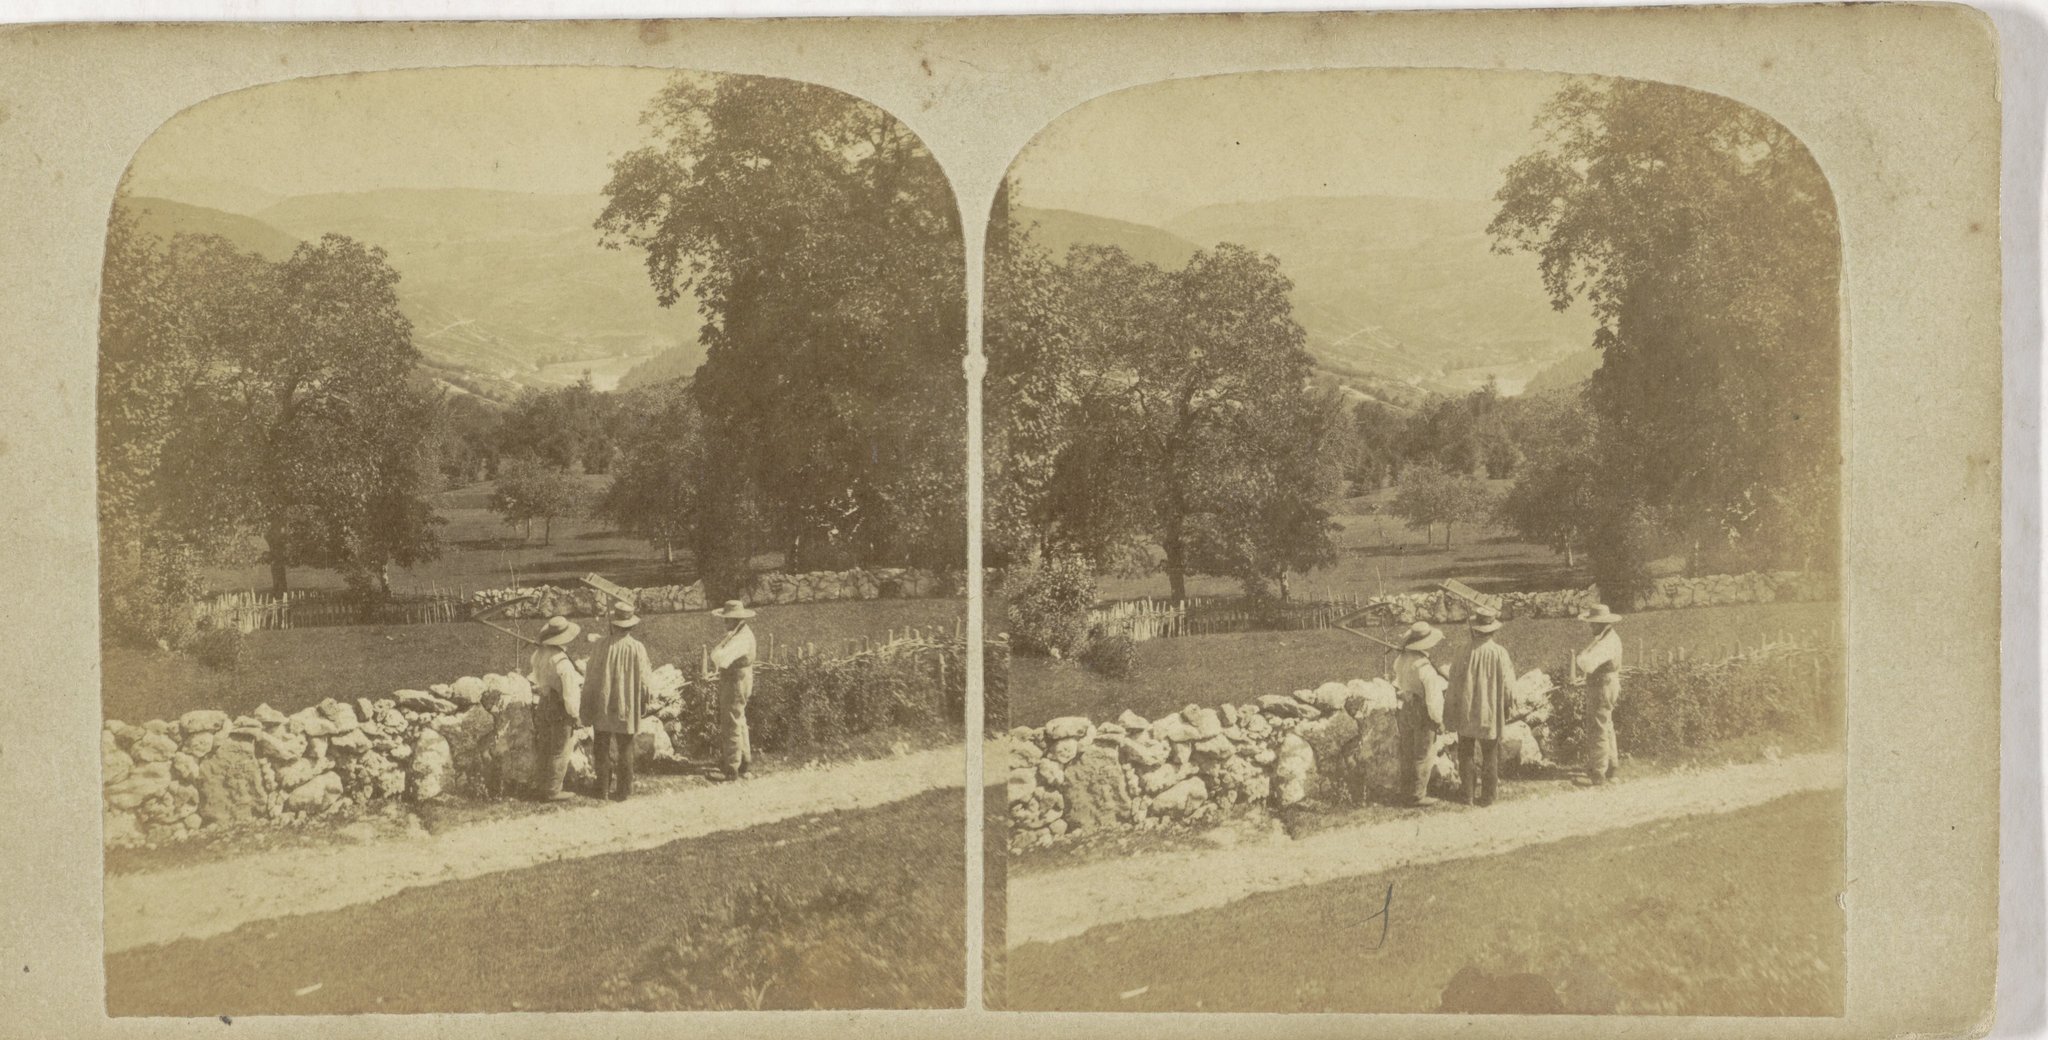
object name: stereograph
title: Berglandschap met drie figuren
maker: Anonymous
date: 1873-1890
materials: cardboard, paper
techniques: albumen print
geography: germany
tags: dale, valley, landscapes (+ landscape with figures, staffage), germany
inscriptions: inscription: ‘99’, inscription: ‘49’, inscription: ‘99’